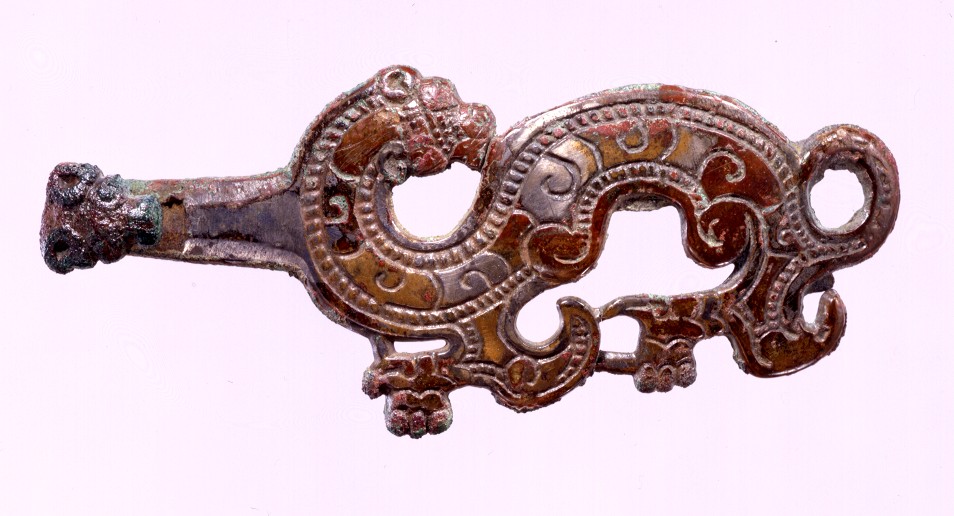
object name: belt hook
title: Feline-Shaped Belt Hook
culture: north chinese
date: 400-201 BCE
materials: bronze